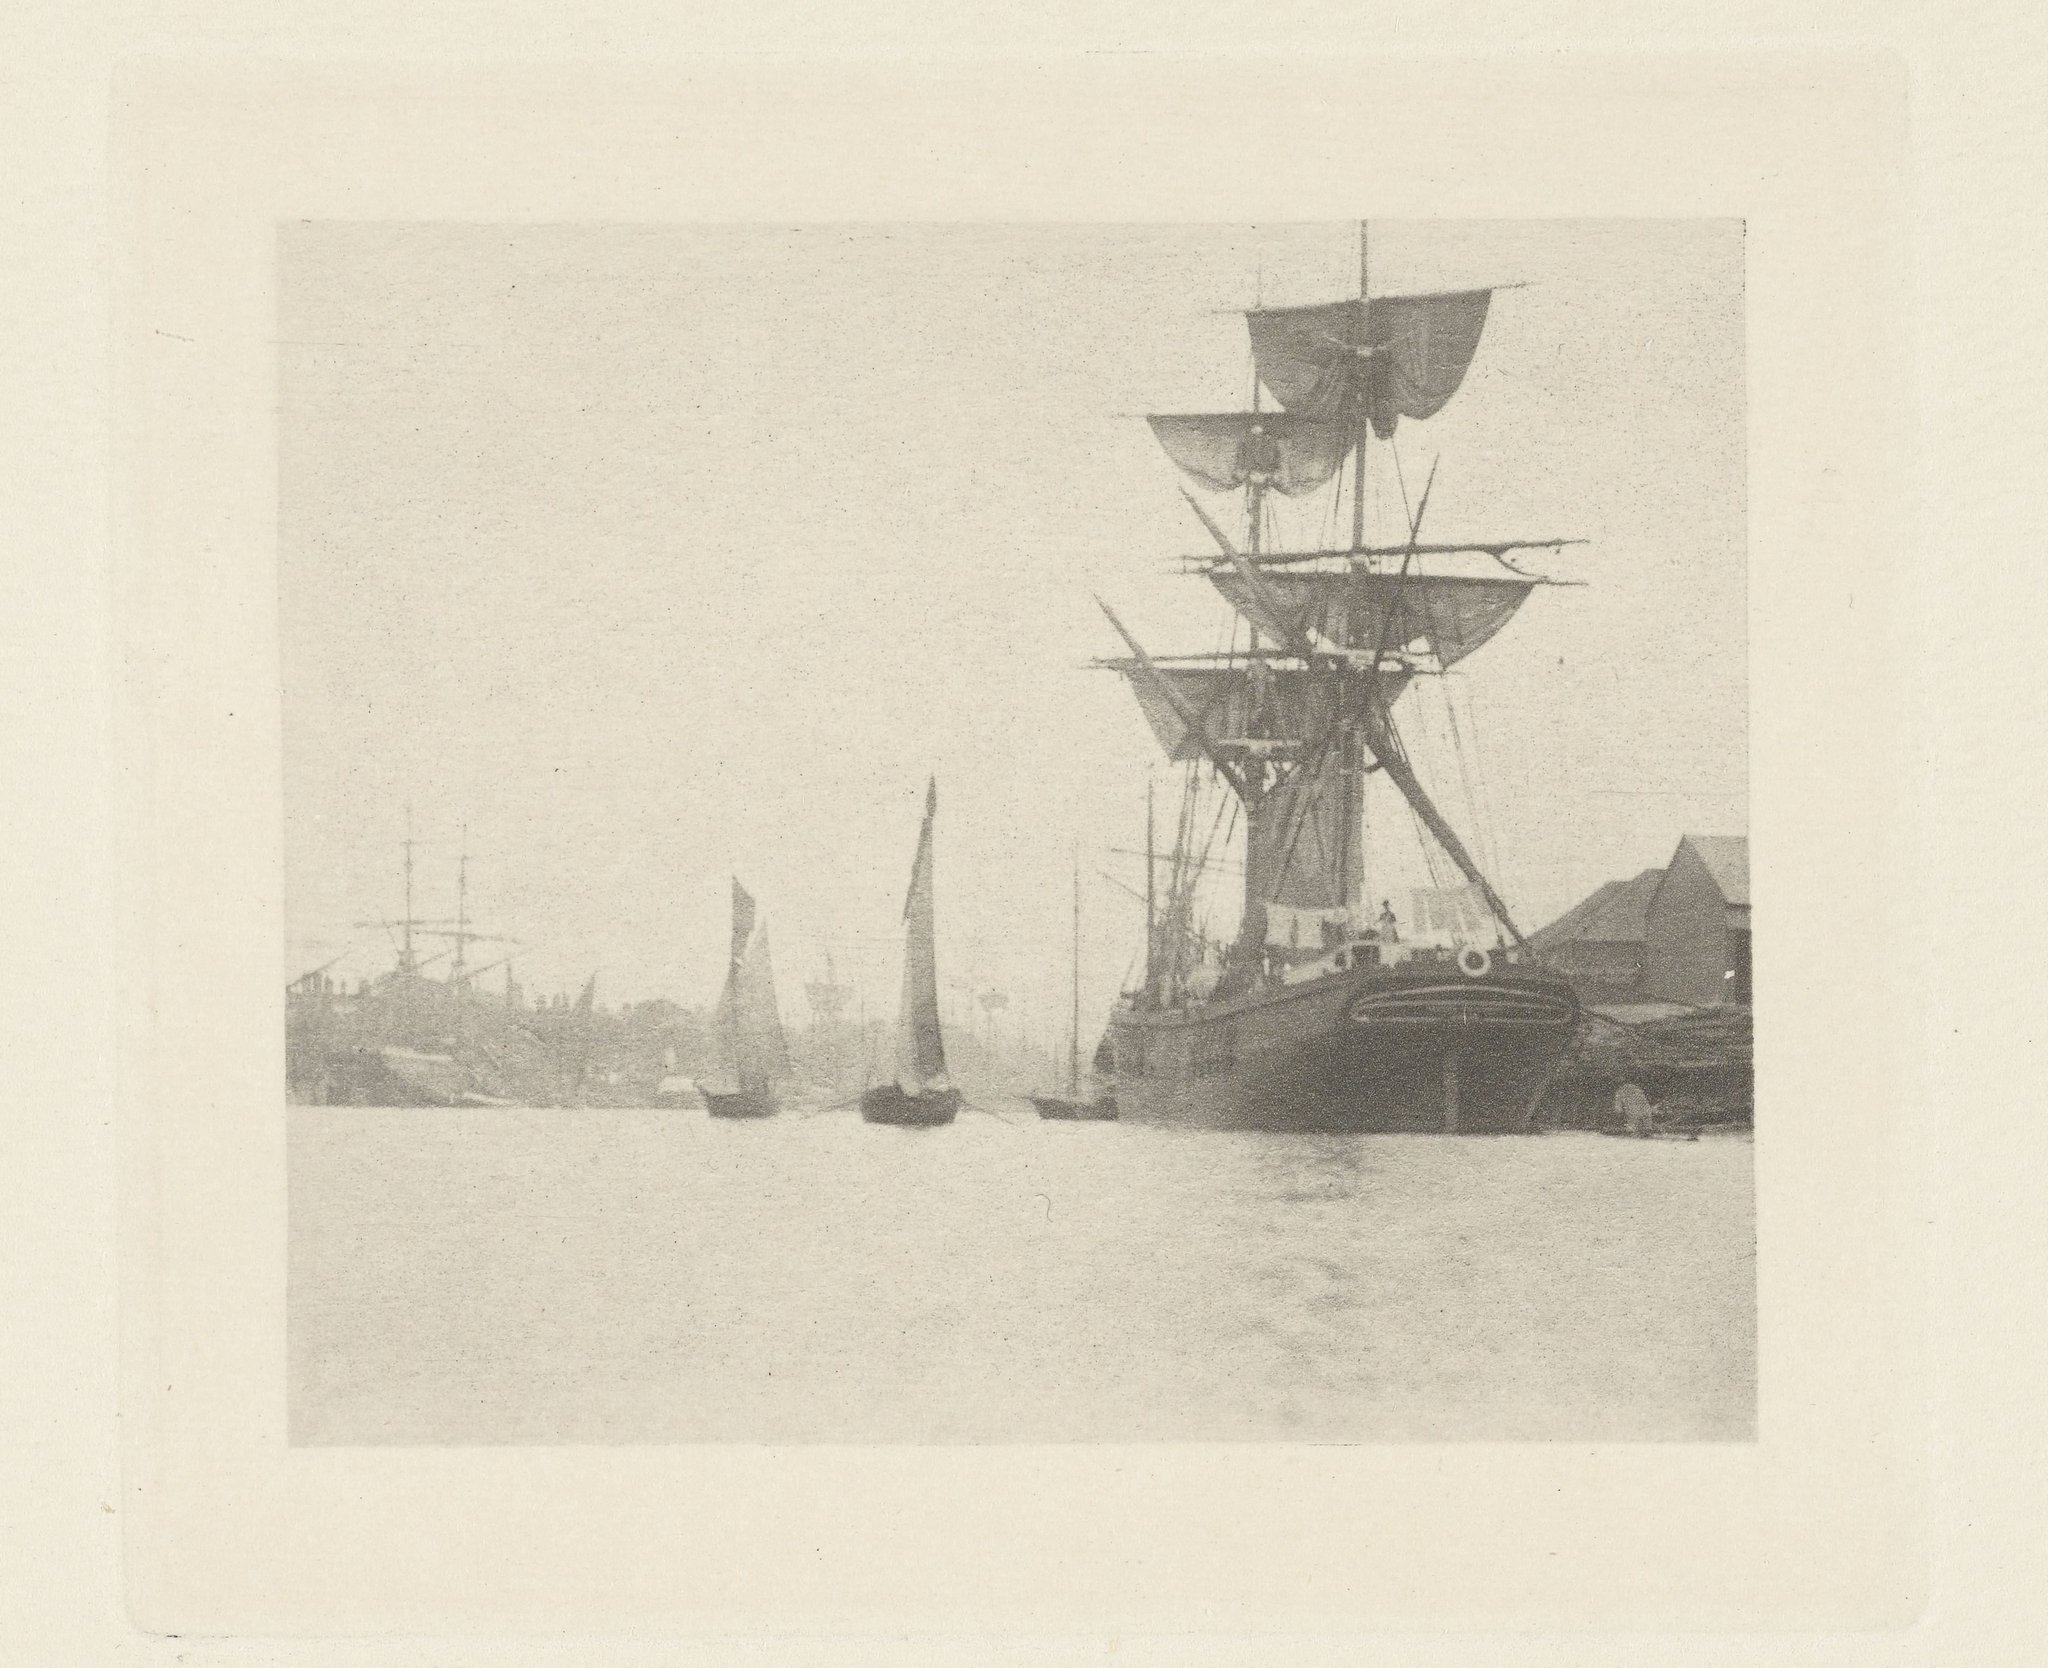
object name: photomechanical print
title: Return of the Shrimpers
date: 1887-1890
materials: paper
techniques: photoaquatint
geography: great britain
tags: ships (in general), great britain